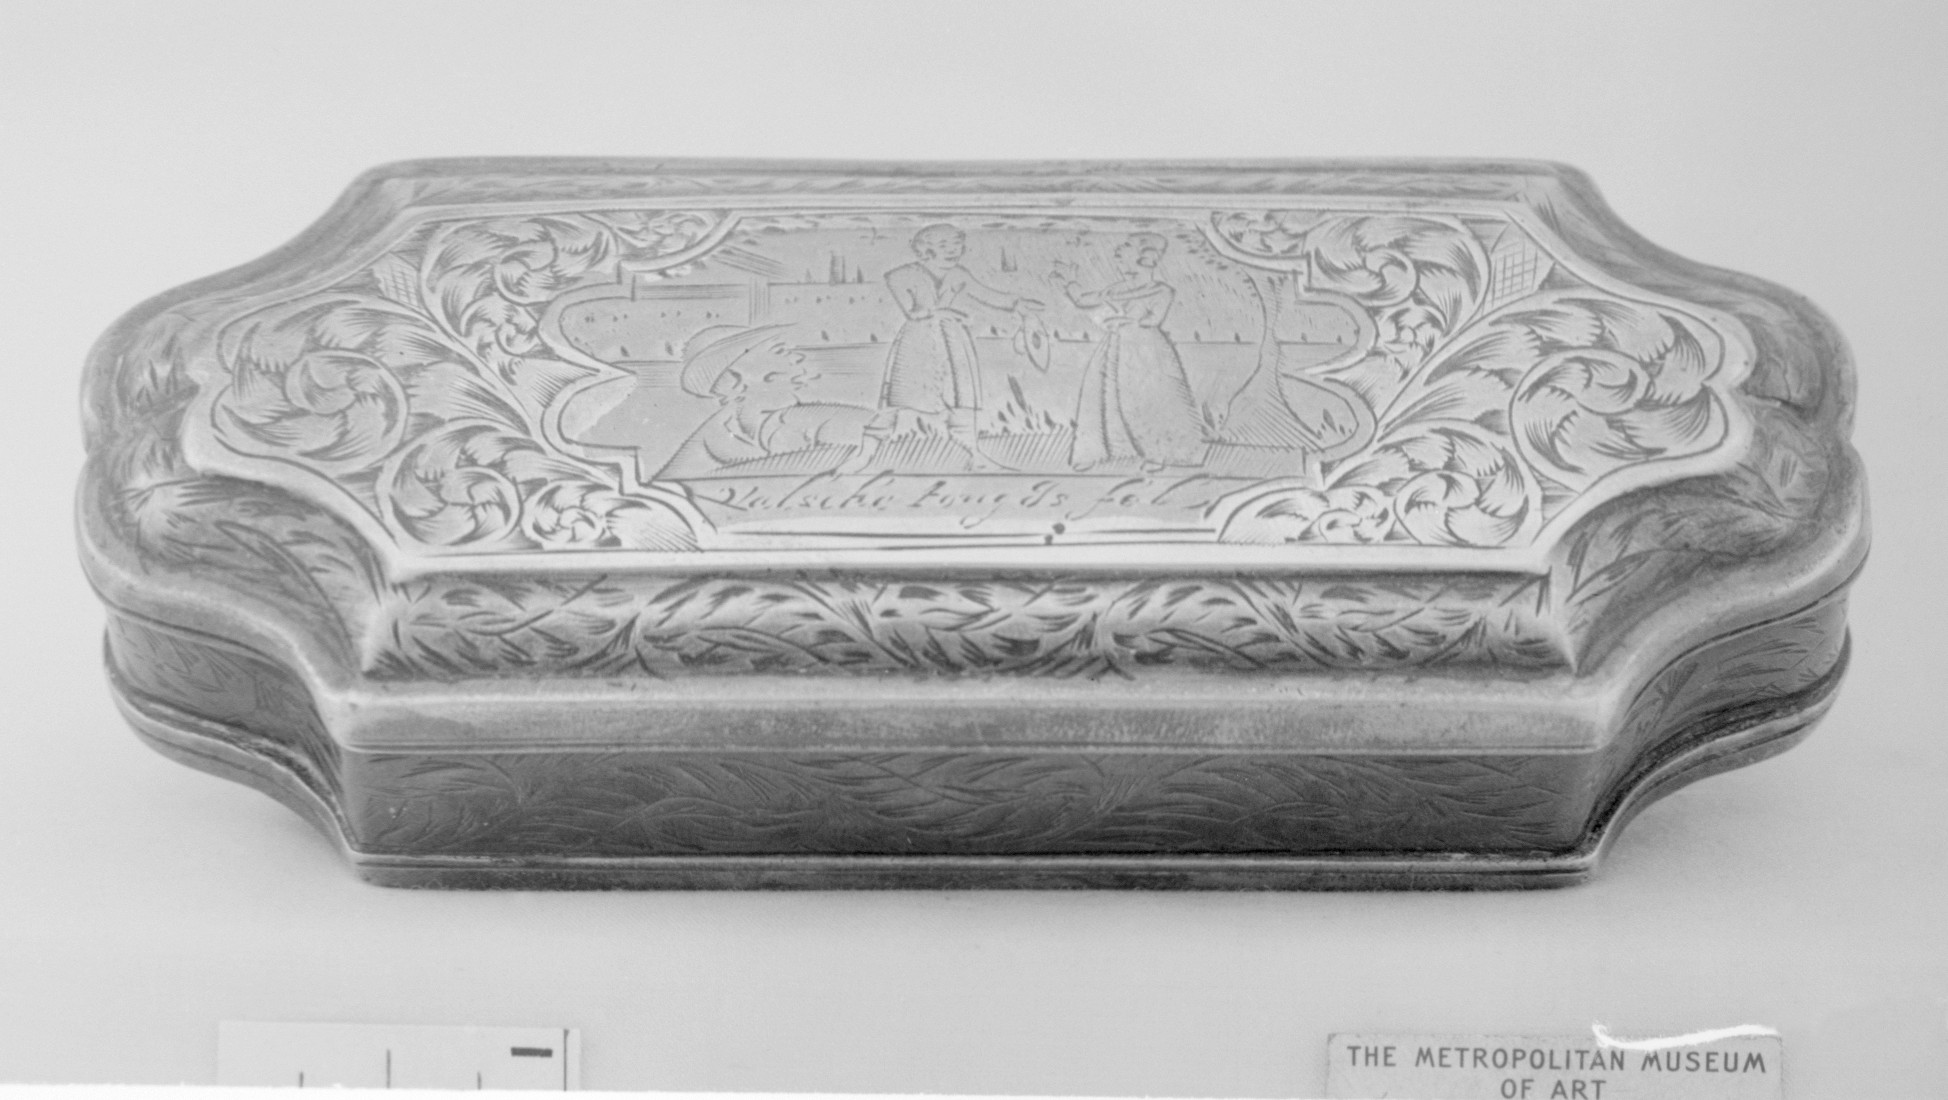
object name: tobacco box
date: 1601-1700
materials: brass, copper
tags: men,women